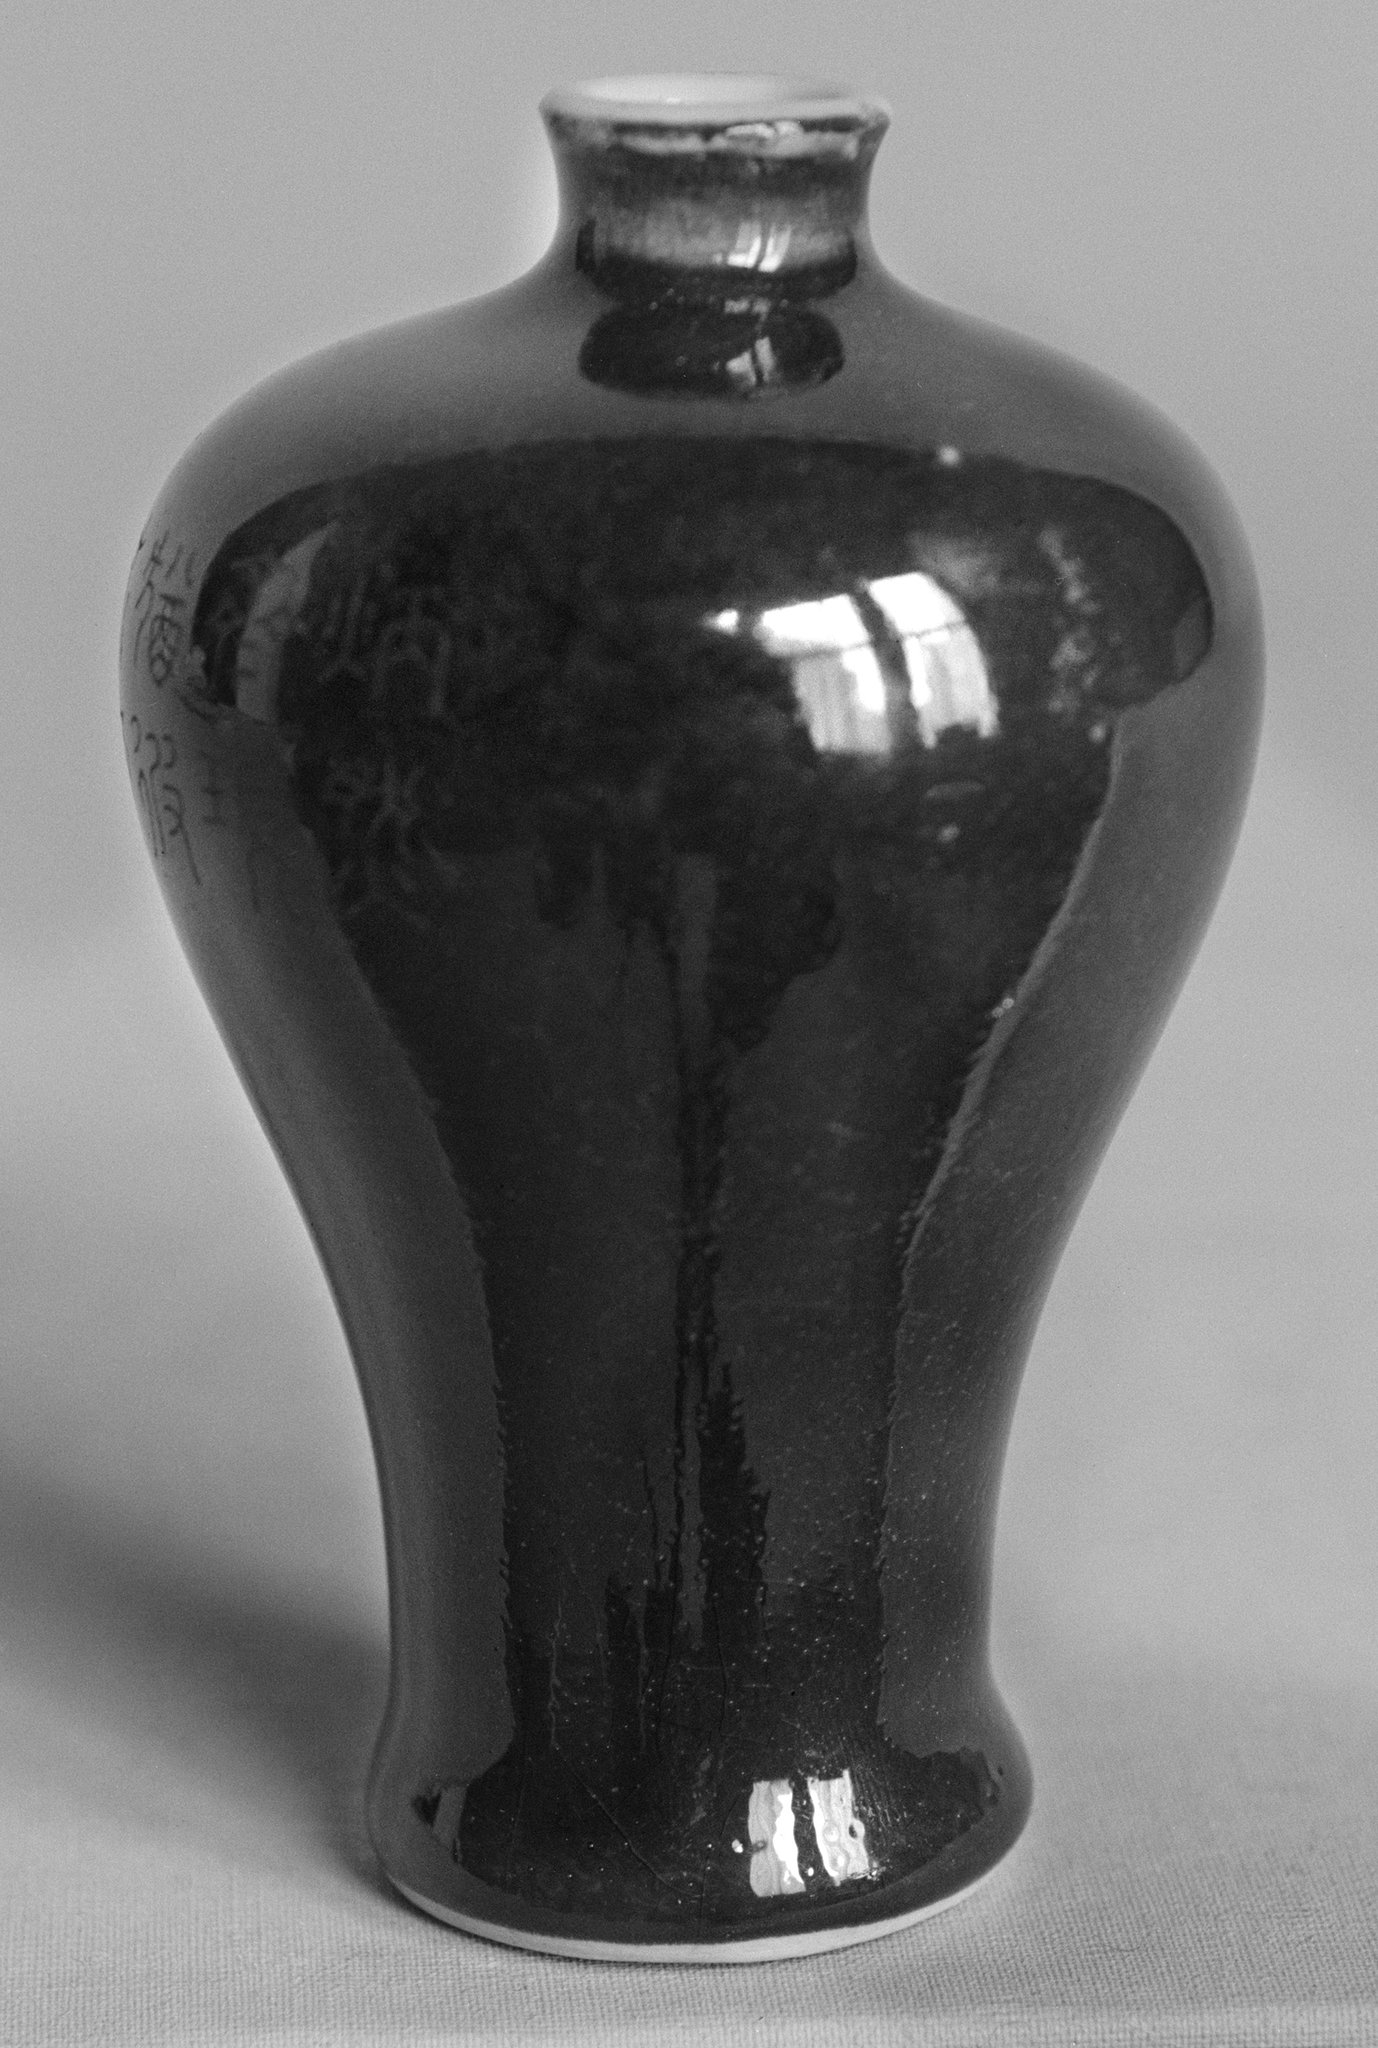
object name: vase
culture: chinese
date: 1662-1722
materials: glaze, porcelain